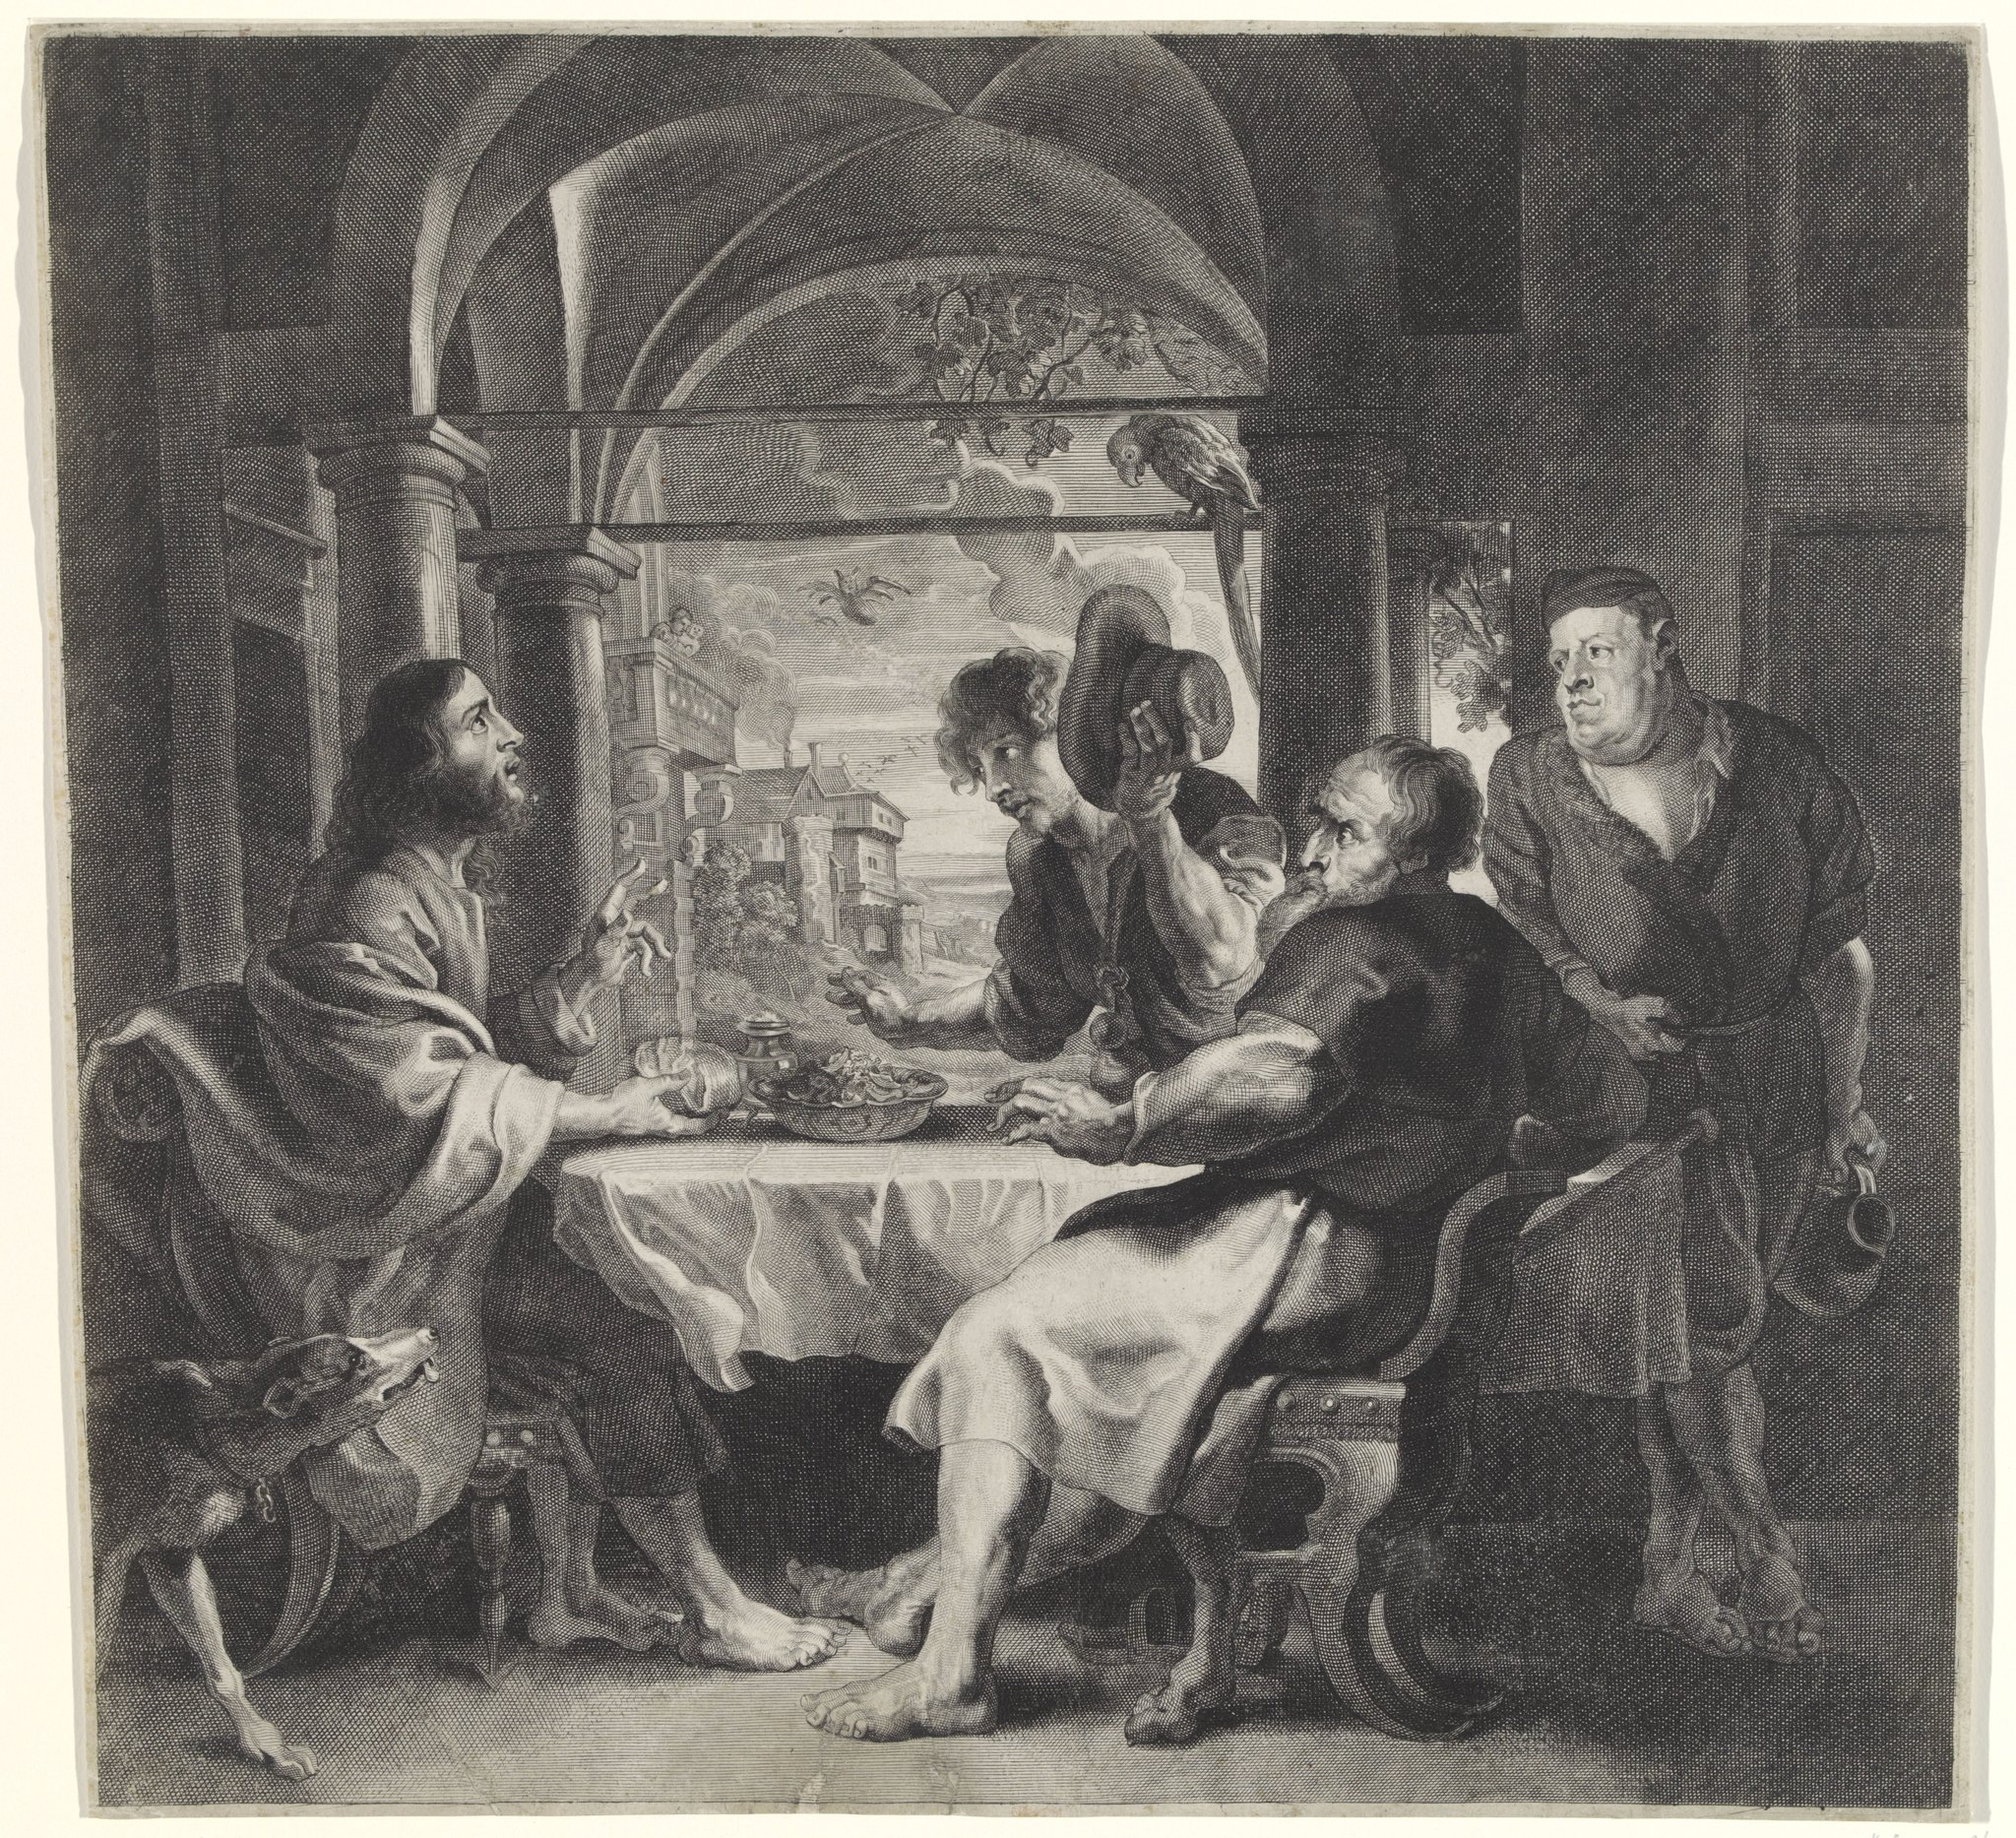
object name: print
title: Maaltijd in Emmaüs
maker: hans witdoeck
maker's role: print maker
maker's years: 1615-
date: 1638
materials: paper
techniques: engraving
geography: antwerp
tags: flying mammals: bat, the supper at emmaus: christ is recognized while blessing or breaking the bread, ornamental birds: parrot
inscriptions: collector's mark: Lugt 240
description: Christus en twee apostelen zitten rond een tafel in een herberg. Christus breekt het brood en maakt zo zijn identiteit bekend. De apostelen reageren geschokt. Boven de tafel een papegaai. Op de achtergrond een landschap en een vleermuis die door de lucht vliegt.